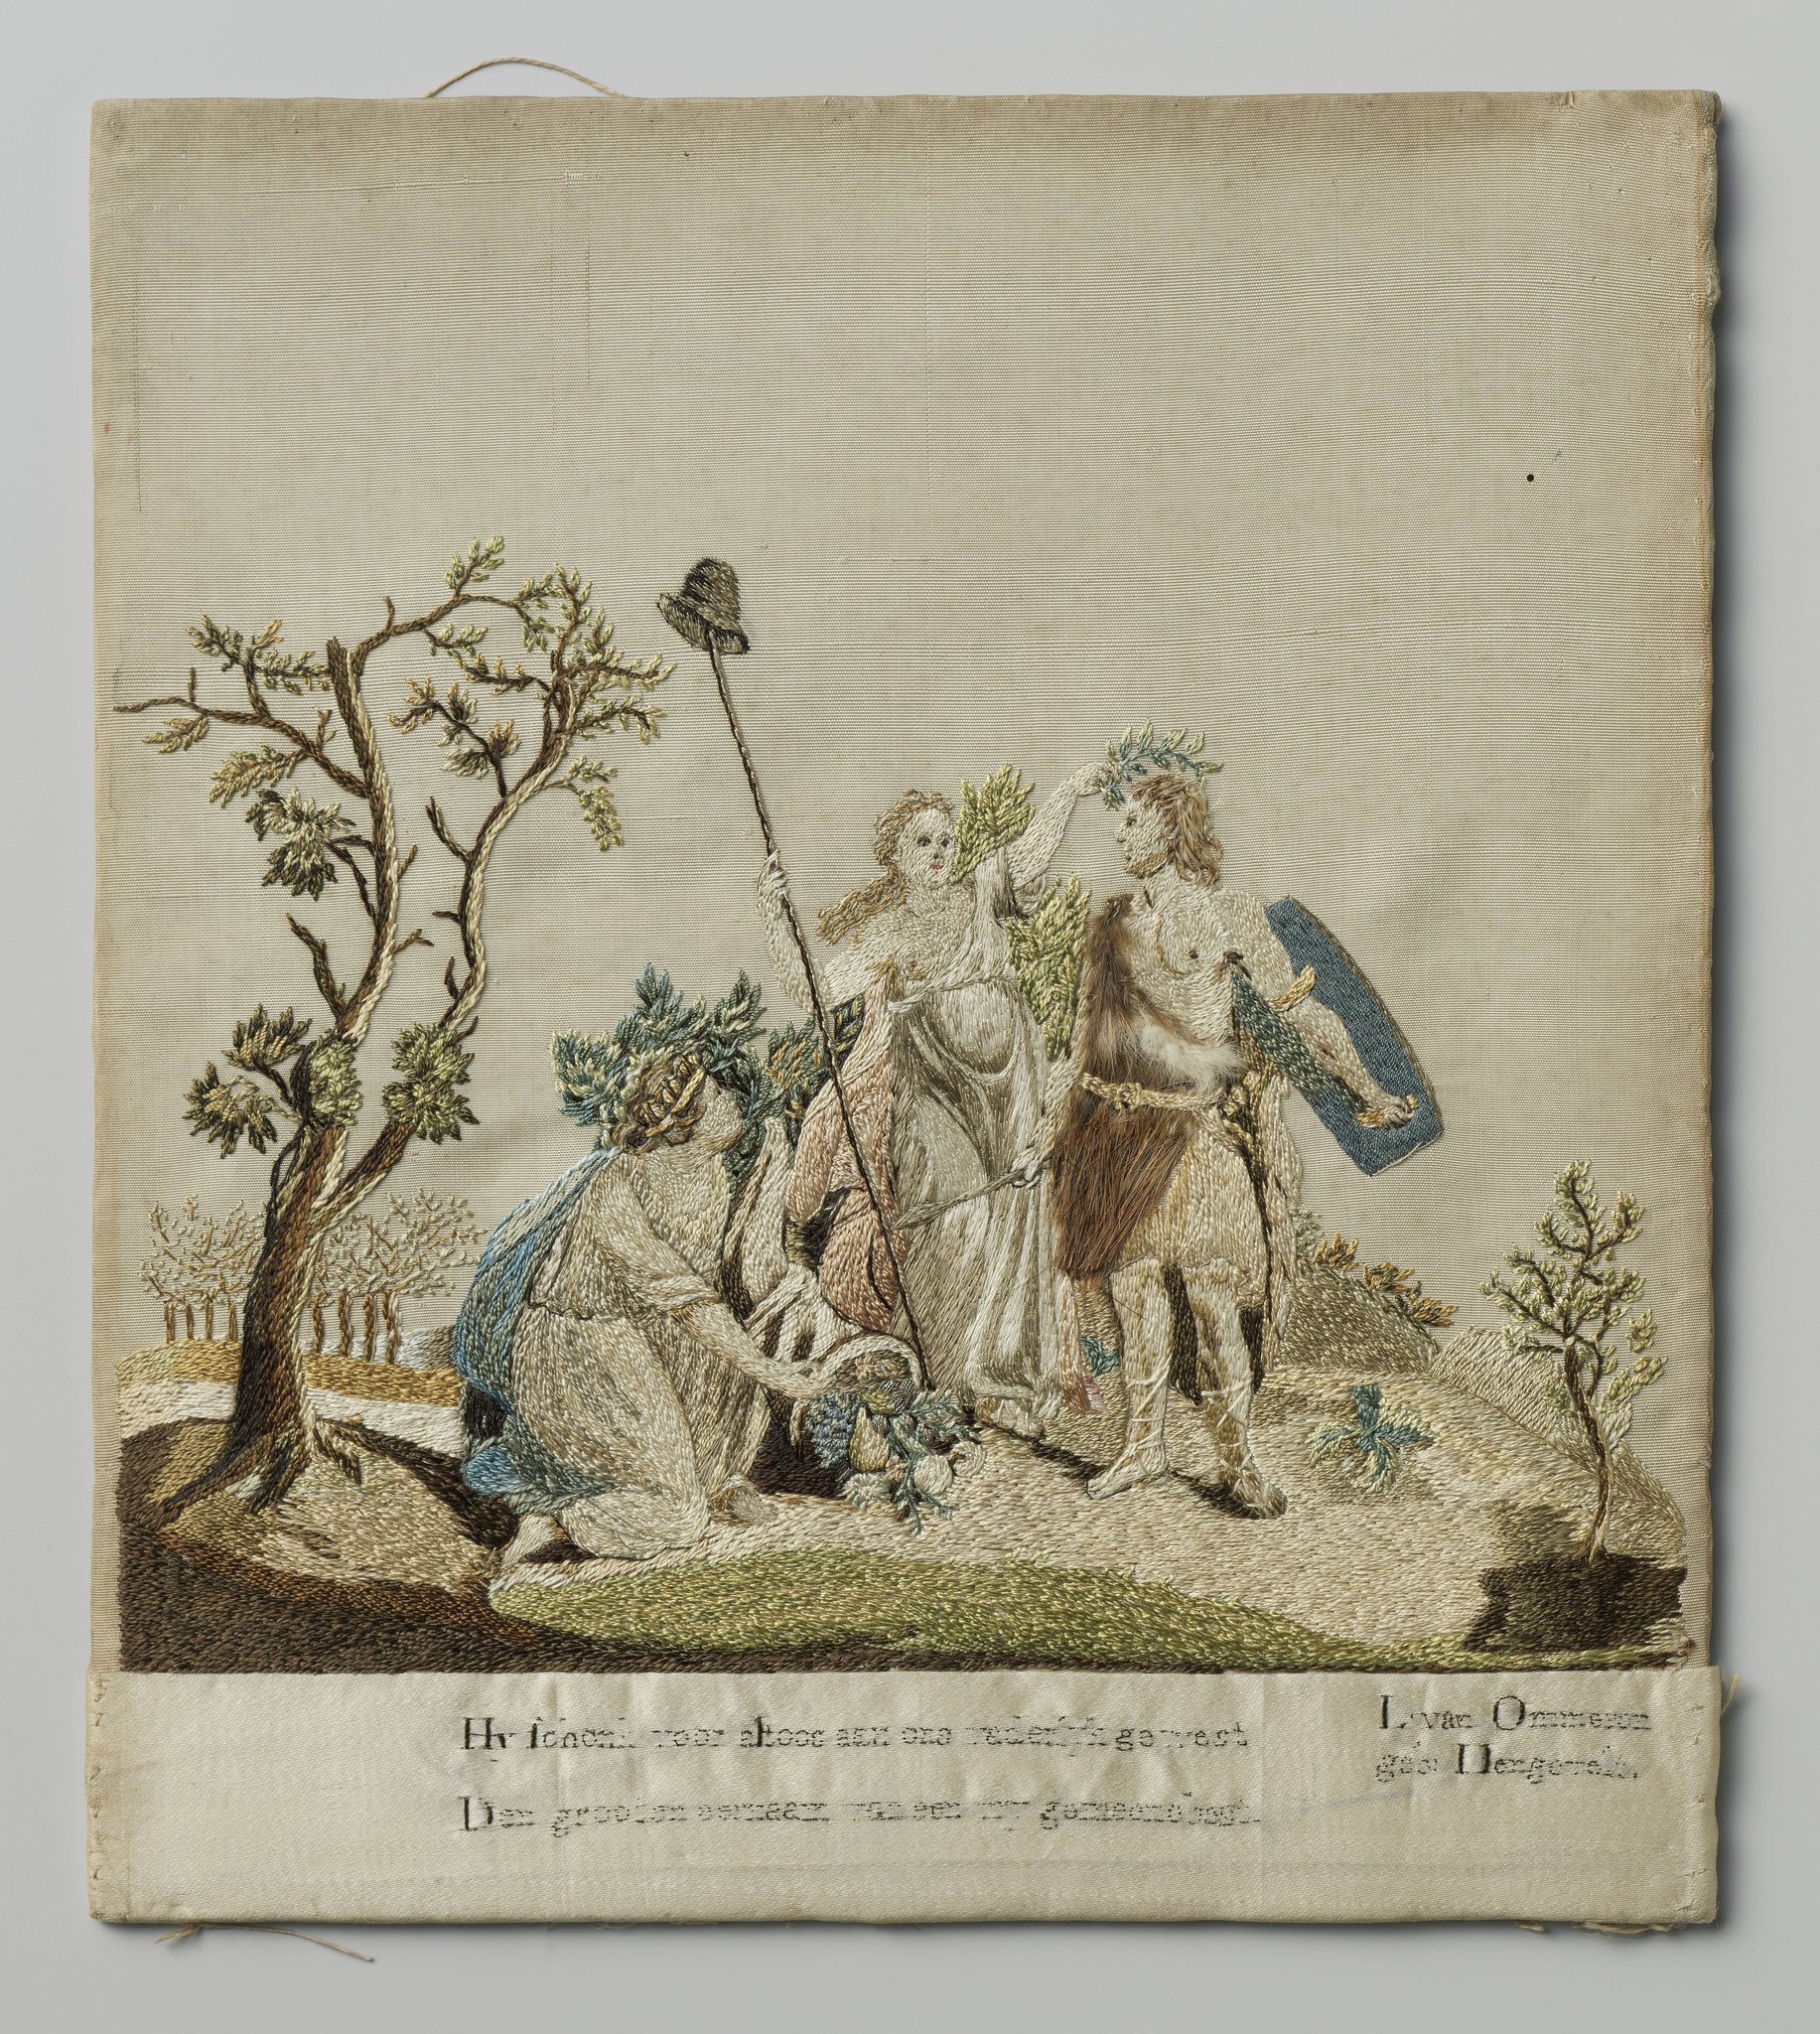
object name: frame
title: Borduurwerk met allegorische voorstelling van Claudius Civilis met de Vrijheid en Overvloed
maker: louise van ommeren-hengevelt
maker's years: 1757-1846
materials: fur, glass, gypsum, silk, wood, yarns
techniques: embroidered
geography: netherlands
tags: abundance; 'abondanza', 'abondanza maritima' (ripa) (+ abstract concept represented by female figure), peace and prosperity, 'pax et abundantia', freedom, liberty; 'libertà' (ripa) (+ abstract concept represented by female figure)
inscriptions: inscription: ‘Hij schonk voor altoos aan ons vaderlijk gewest / Den grooten eernaam van een vrij gemeenebest’, signature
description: Een Batavier gehuld in bont wordt gelauwerd door de personificatie van de vrijheid die in haar linkerhand een lauwerkrans houdt en in haar rechterhand een lange lans met daarop een vrijheidshoed. De personificatie van de overvloed is links van deze twee figuren geknield bij een hoorn des overvloeds (een mand met bloemen en fruit). De drie personen zijn geplaatst in een heuvellandschap met links een enkele boom met afgebroken en kale takken en in het verschiet een groepje bomen vol in blad. Op een apart stukje stof is een onderschrift geborduurd en vervolgens gemonteerd op de stof met de geborduurde voorstelling.